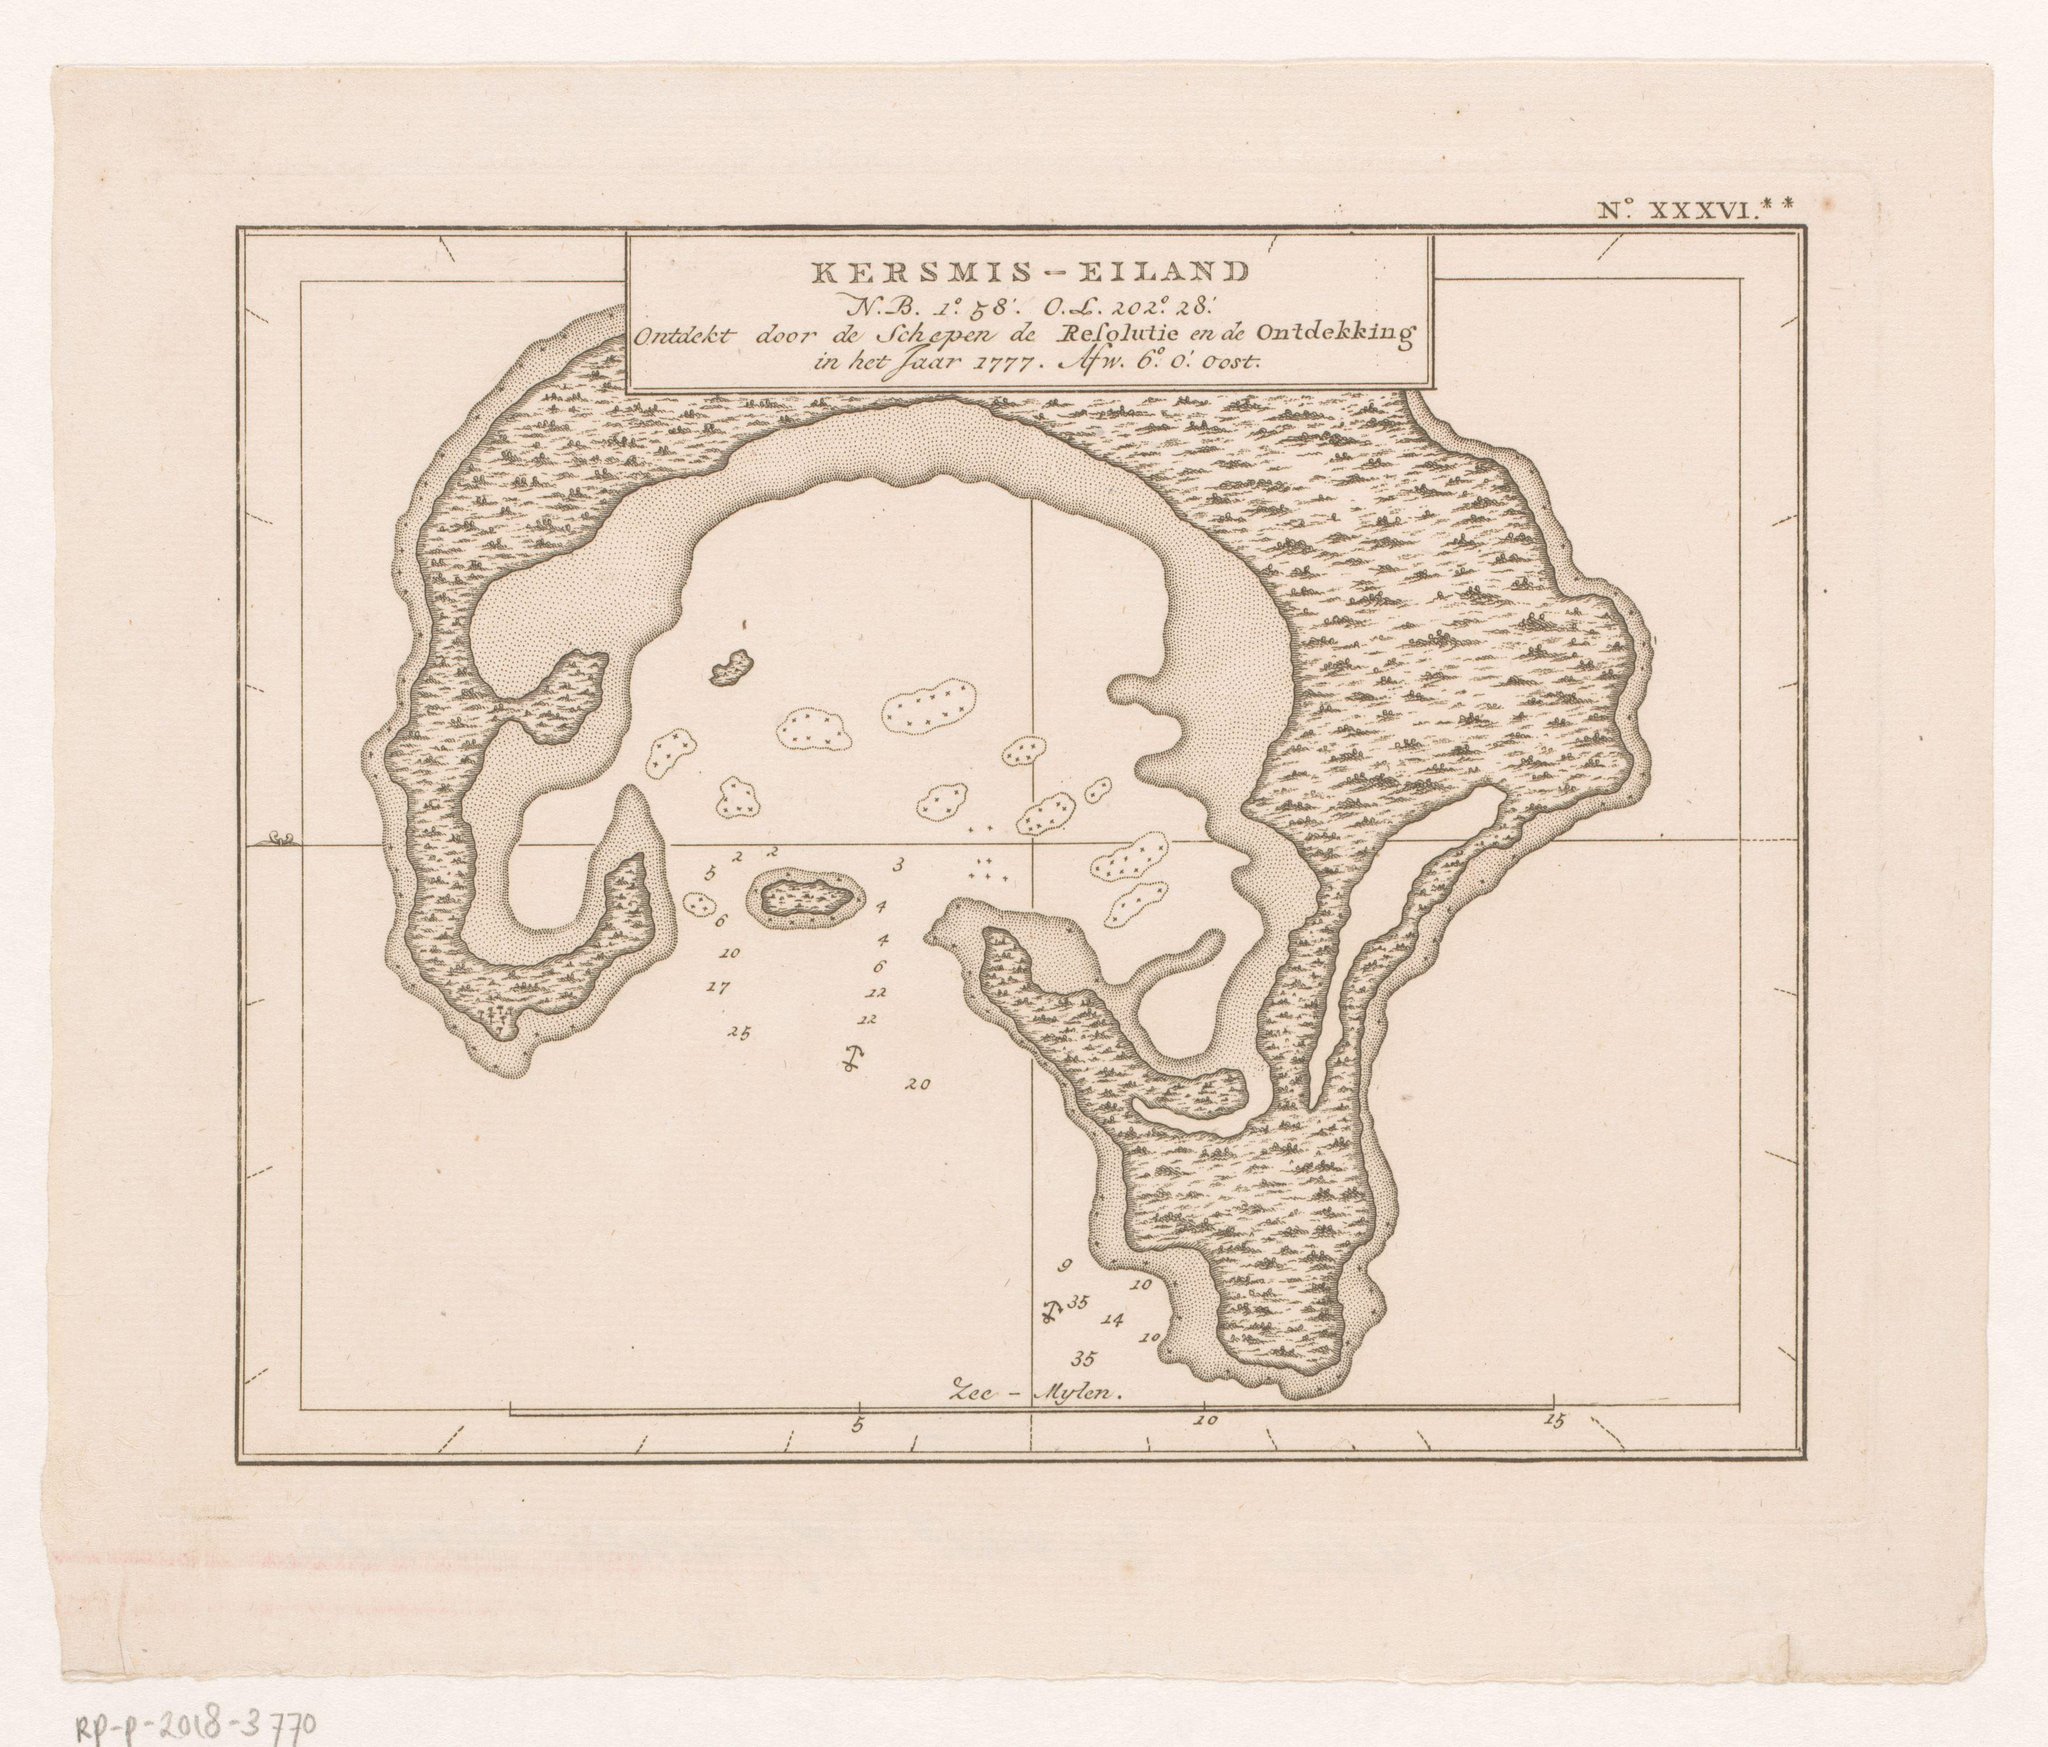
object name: book illustration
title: Kaart van het atol Kiritimati in de Grote Oceaan, door James Cook in 1777 ontdekt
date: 1802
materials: paper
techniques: etching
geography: leiden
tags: island, maps, atlases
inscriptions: collector's mark: Lugt 2228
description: Prent uit: Cook, James. Reize rondom de Waereld (...) met kaarten en plaaten. [Vertaald uit het Engels door] Jan David Pasteur. Leiden: Honkoop, Amsterdam: Allart, Den Haag: Van Cleef, 1802, dl. 10, p. 280.